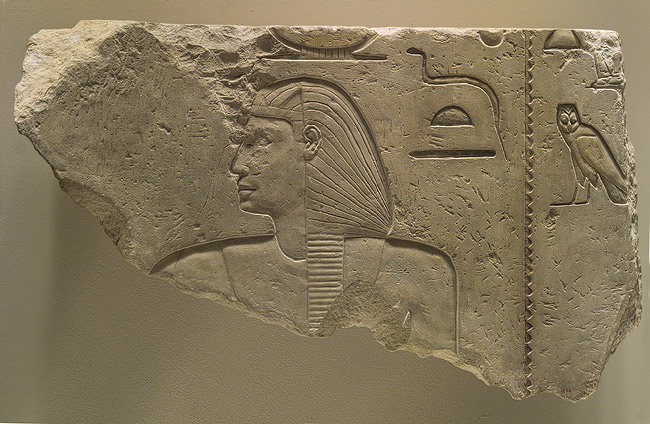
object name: relief, senwosret i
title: Ritual Scene with Senwosret I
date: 1961-1917 BCE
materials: limestone, paint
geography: egypt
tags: kings,owls,snakes